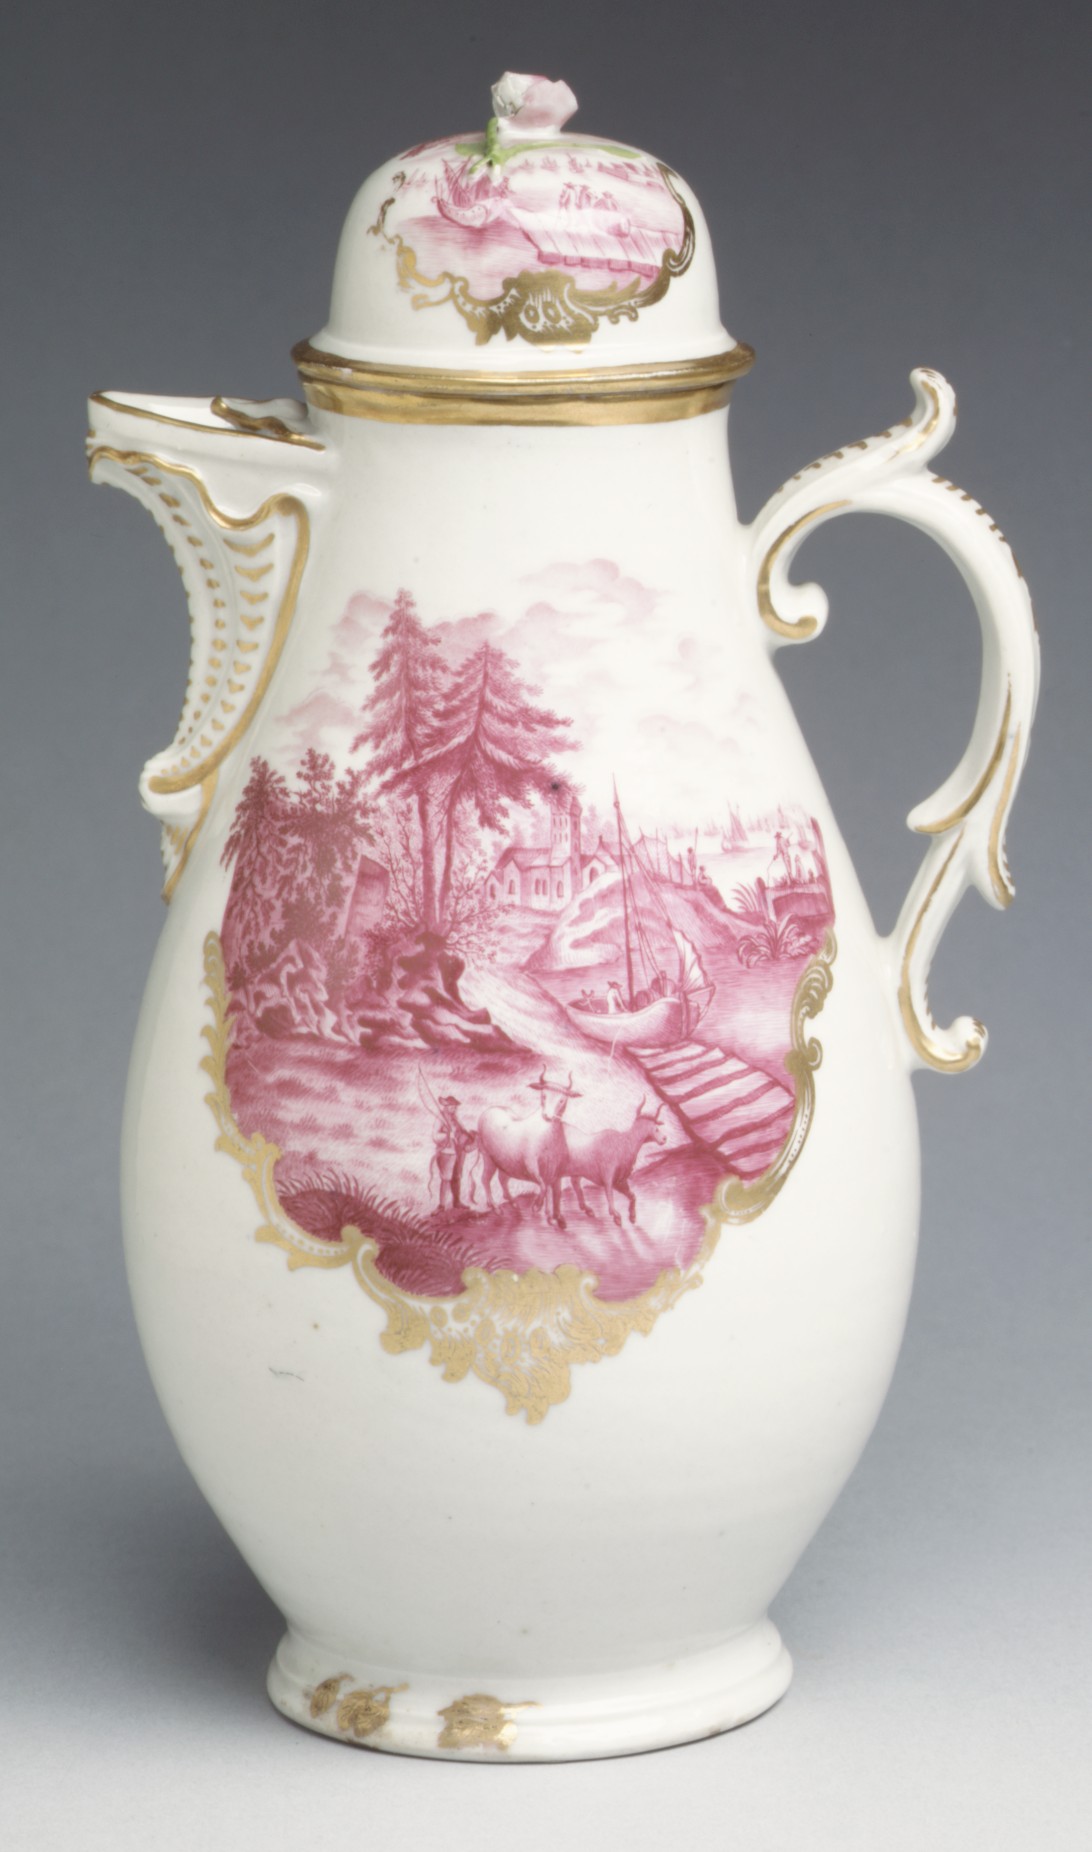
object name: coffeepot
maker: volkstedt porcelain manufactory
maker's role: manufactory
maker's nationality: german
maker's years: 1760-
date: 1770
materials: hard paste porcelain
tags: animals,men,landscapes,trees